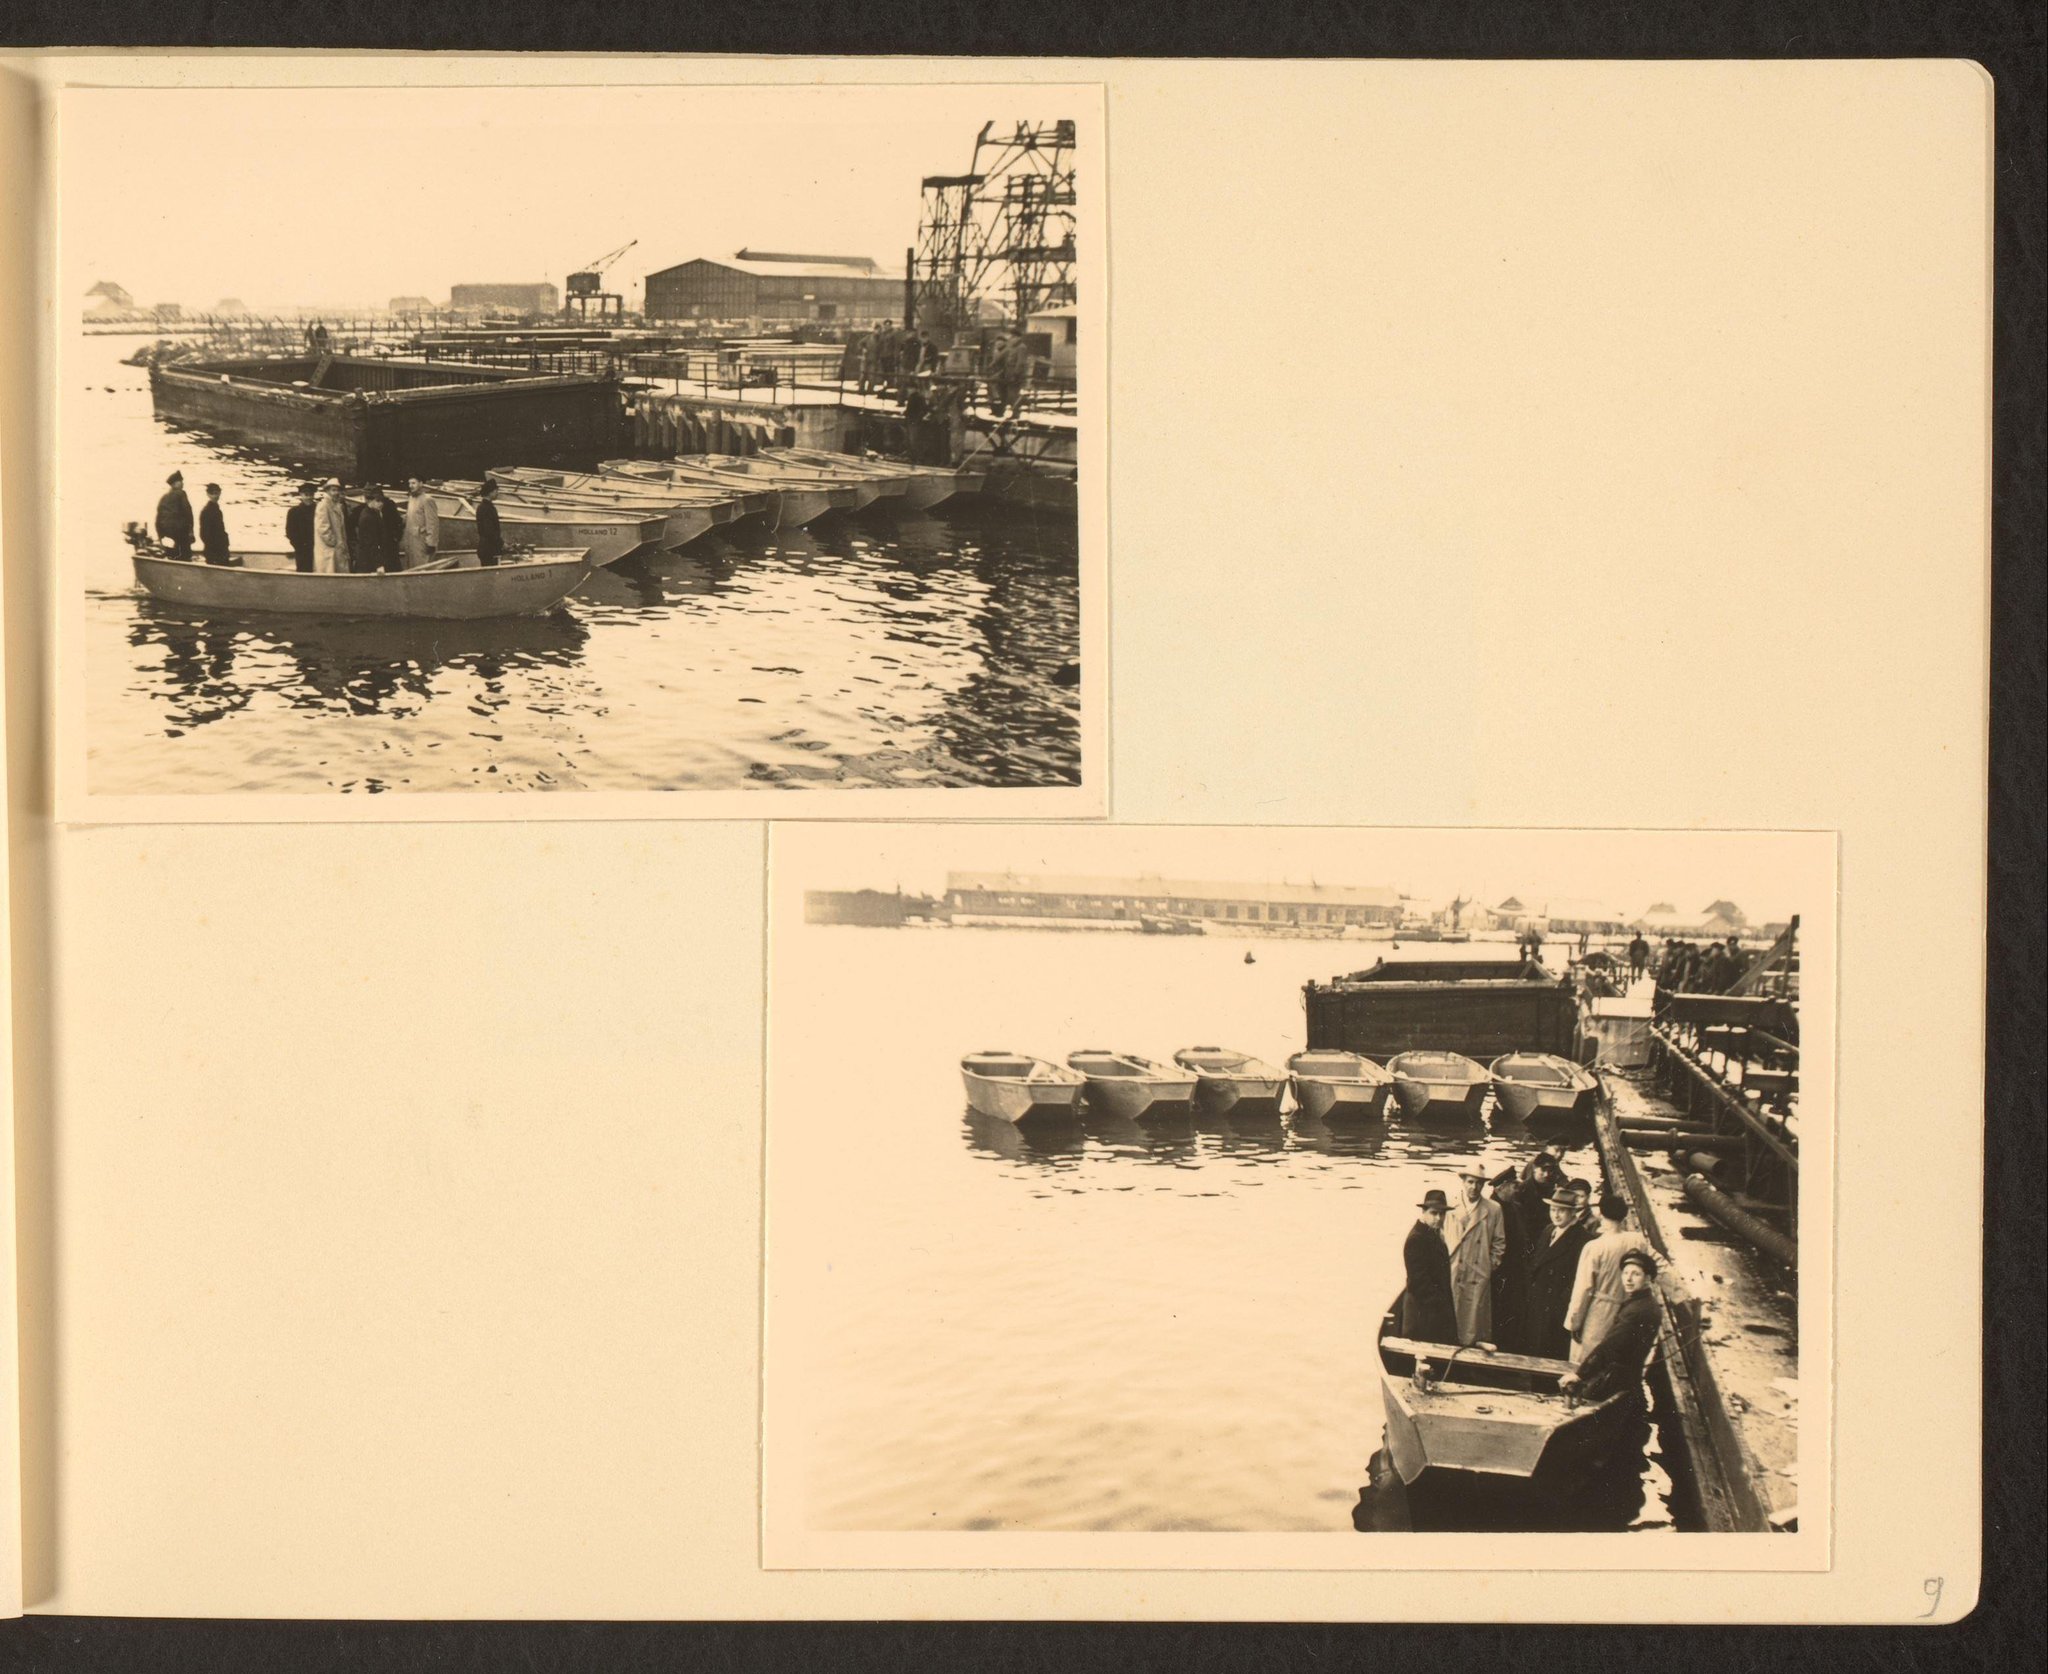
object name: photograph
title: Zeven sloepen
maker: Anonymous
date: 1902-1953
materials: paper, photographic support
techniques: gelatin silver print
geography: emden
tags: building a ship, ship under construction, pier, quay, wharf, steamship, motorship, north sea flood of 1953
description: Albumblad met twee foto's van zeven van de metalen sloepen, gebouwd door Nordseewerke Emden, in het water. Onderdeel van het fotoalbum 'Emden hilft Holland'.